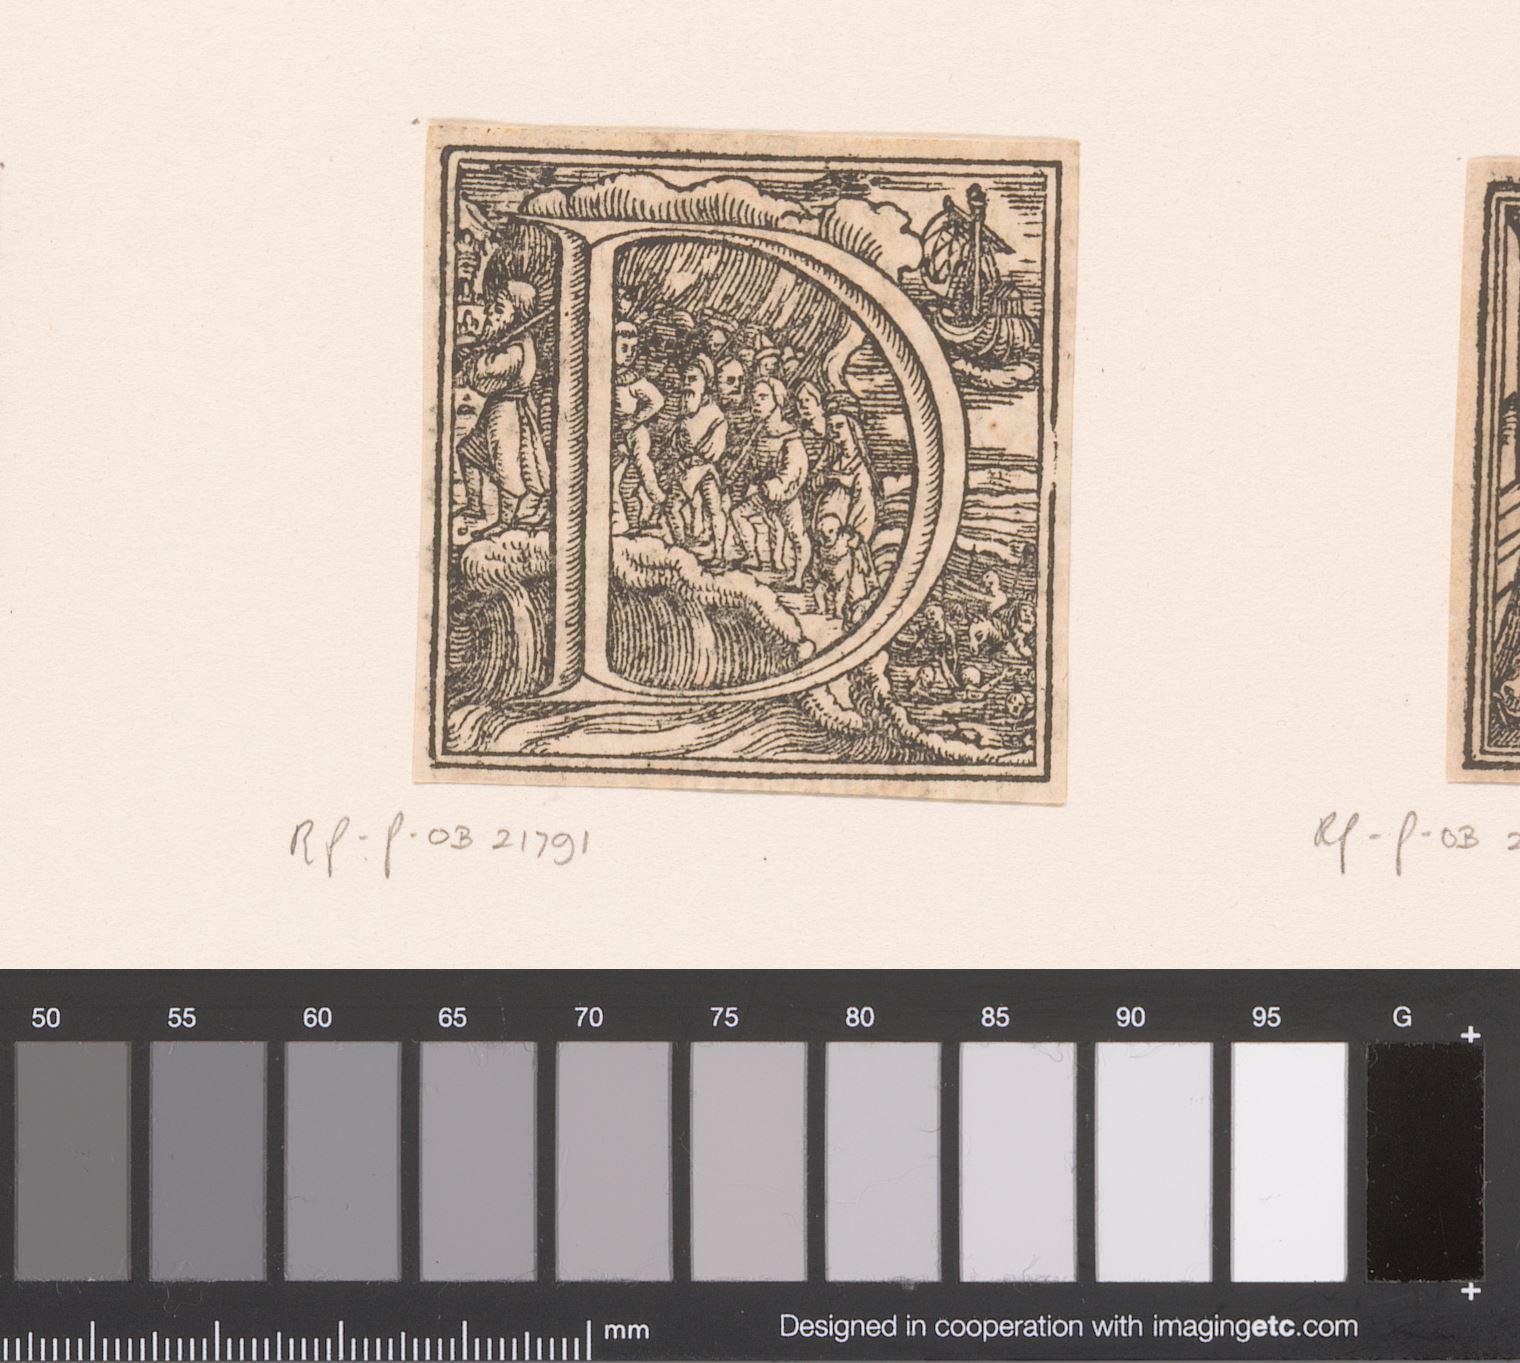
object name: print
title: Letter D: de doortocht door de Rode Zee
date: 1556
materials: paper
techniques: letterpress printing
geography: zurich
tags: initial, passage through the red sea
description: Prent afkomstig uit: Bibel, die gantze, das ist alle Bücher alts und news Testaments (...). Zürich: Johann Froschauer, 1556.